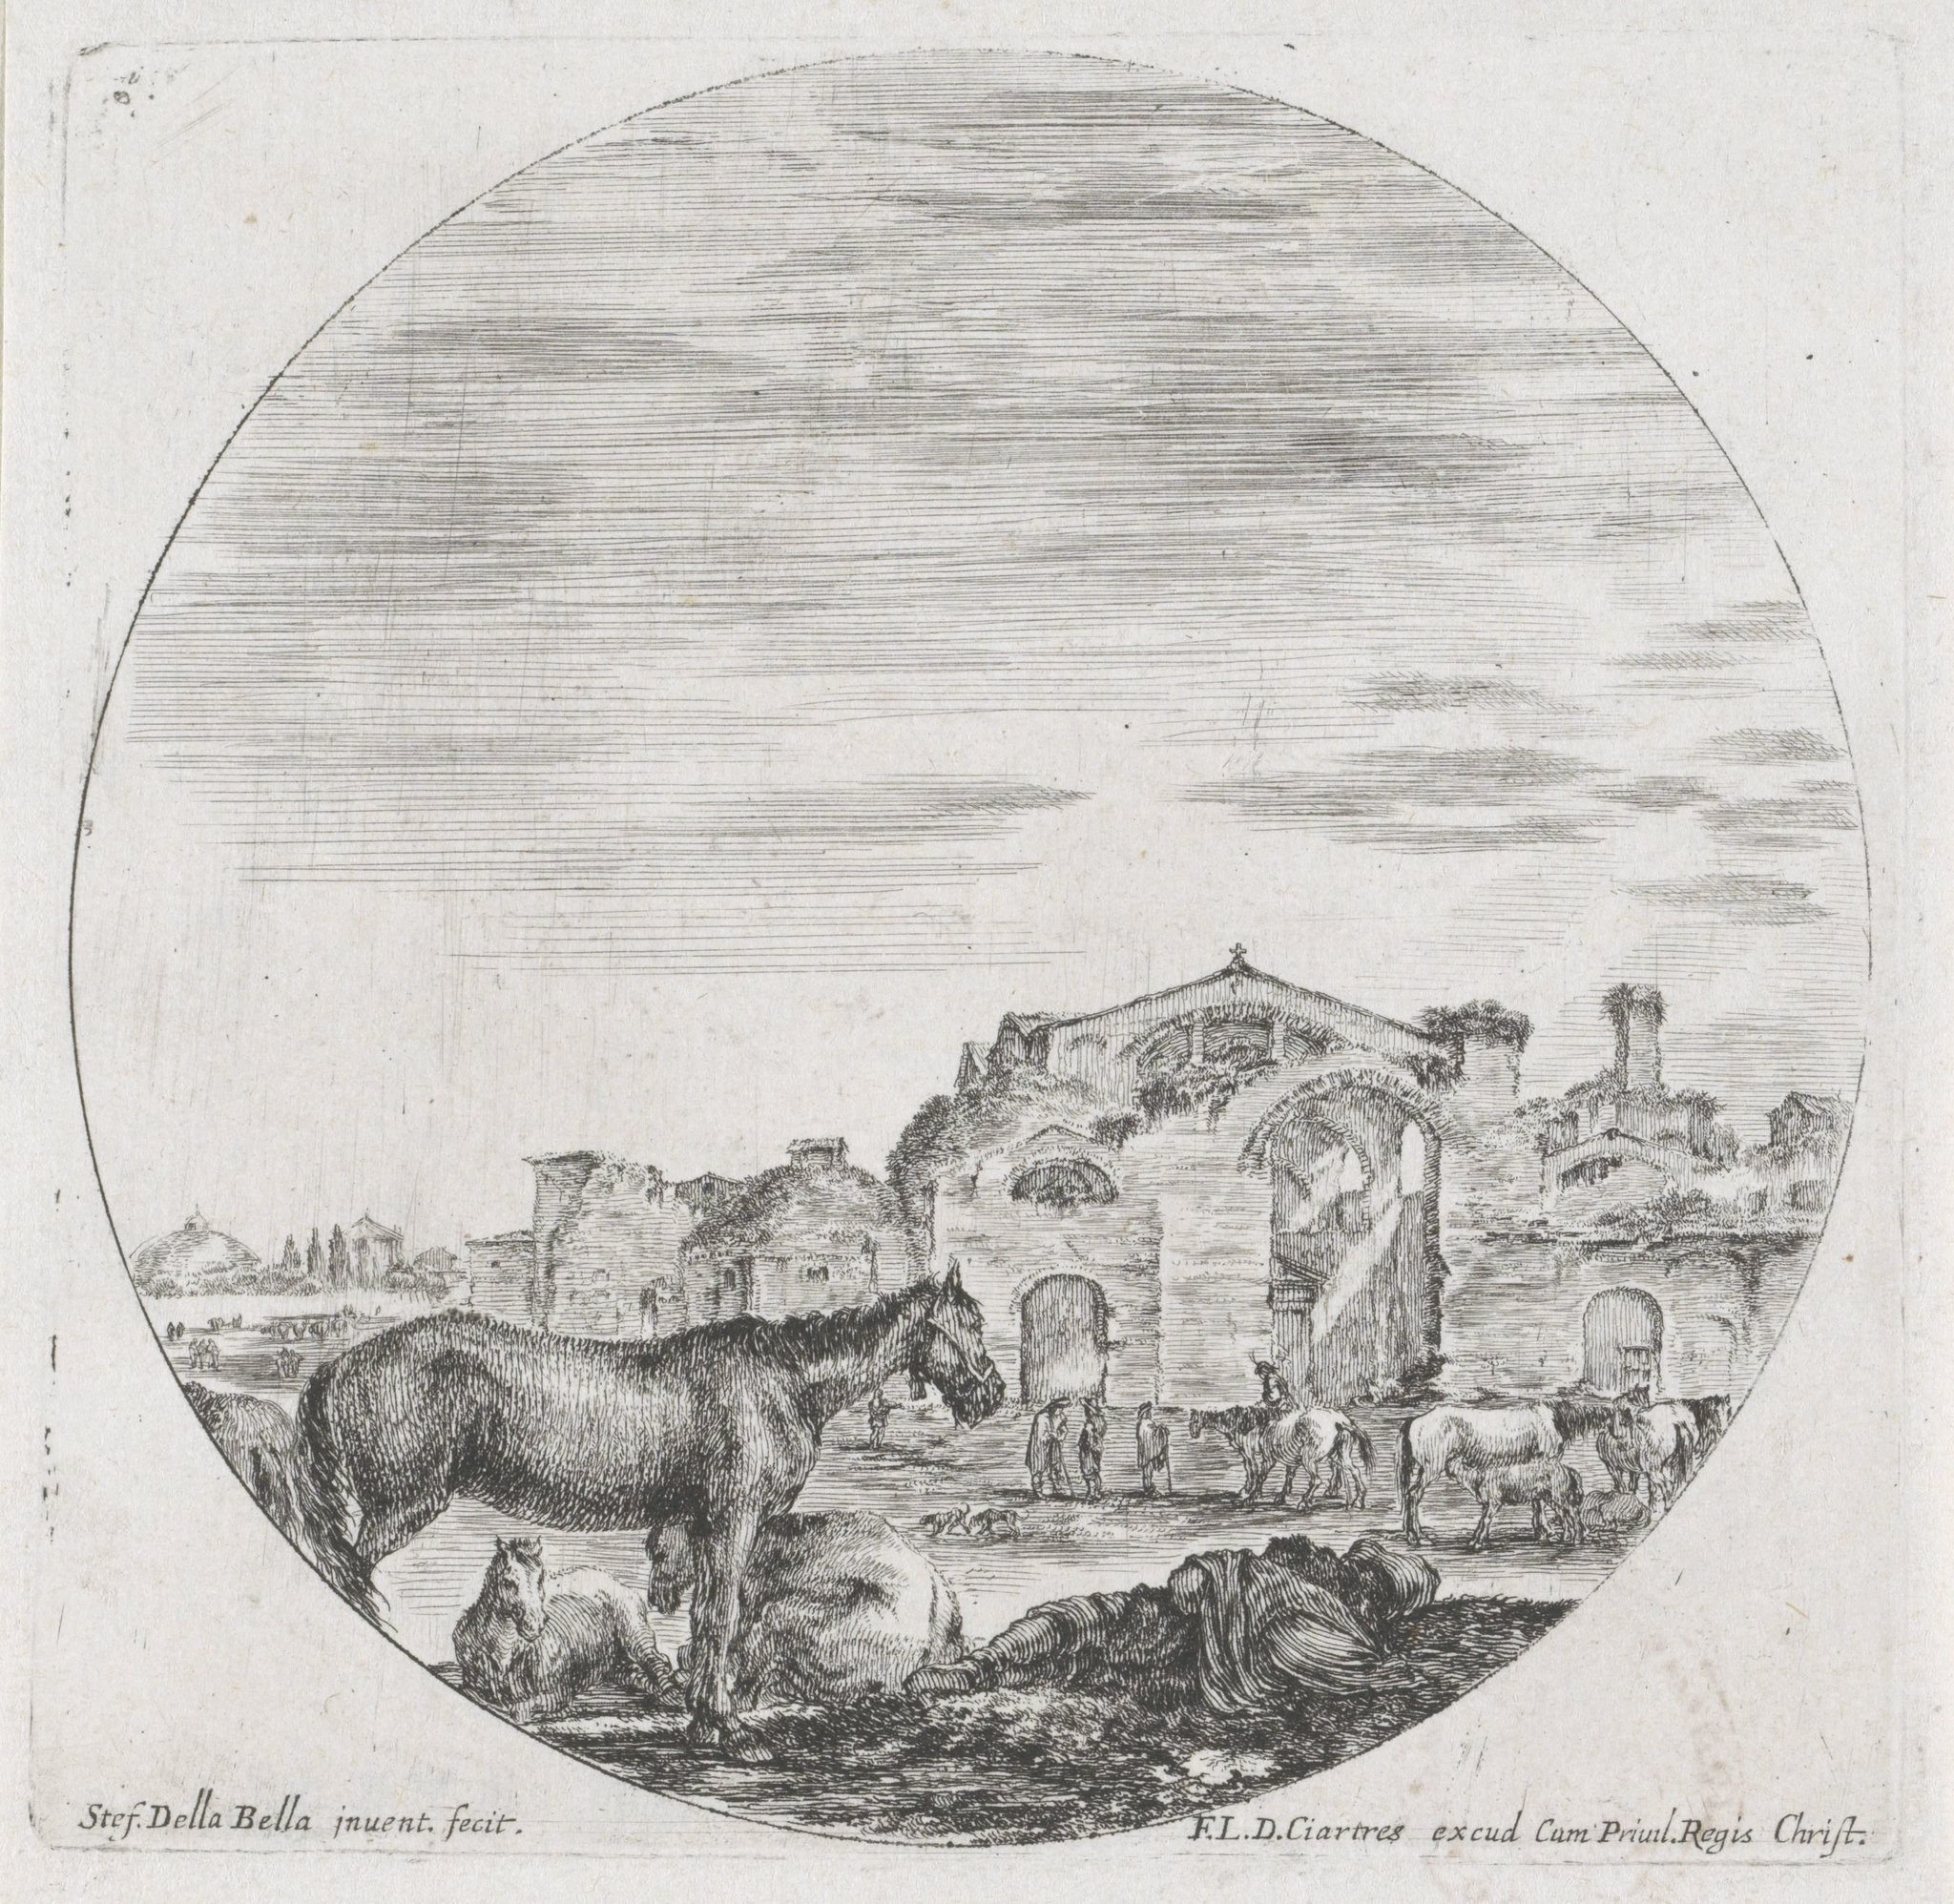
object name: print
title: Paysages et ruines de Rome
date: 1620-1664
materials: paper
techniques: etching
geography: france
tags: herding, herdsman, herdswoman, shepherd, shepherdess, cowherd, etc., ruin of a building ~ architecture, sleeping on the ground, horse, rome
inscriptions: collector's mark: Lugt 240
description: Een landschap met een slapende herder met zijn paarden op de voorgrond. Op de achtergrond andere herders met paarden voor de resten van de Thermen van Diocletianus.